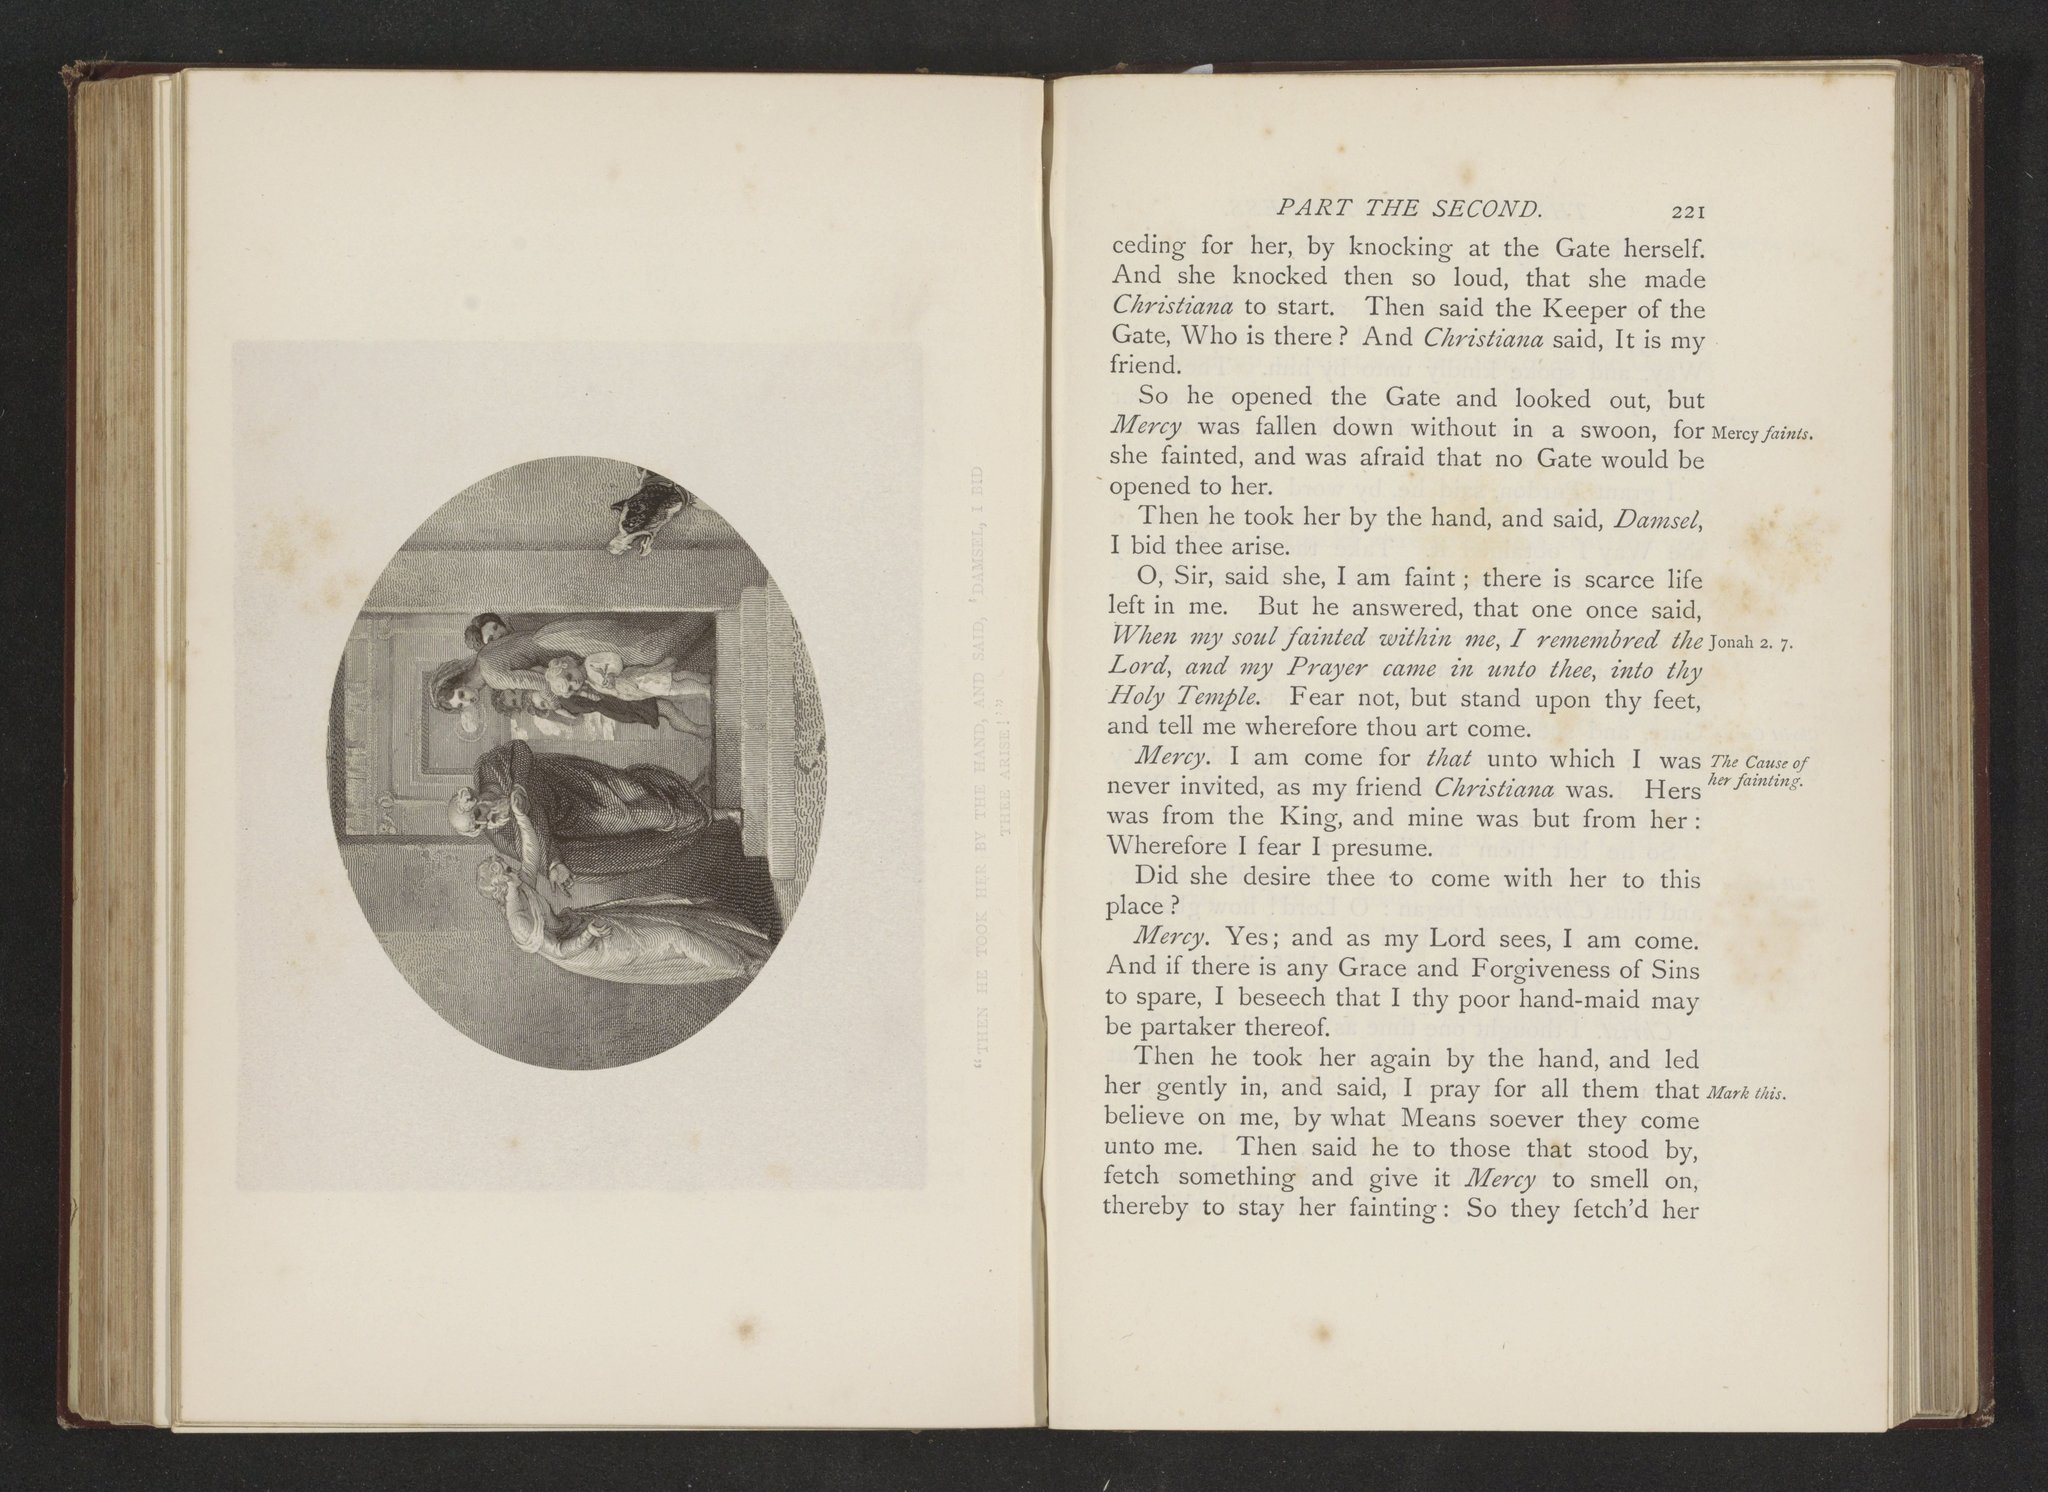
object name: reproduction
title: Fotoreproductie van een illustratie door Thomas Stothard voor Eens Christens reize naar de Eeuwigheid door John Bunyan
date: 1871-1881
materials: paper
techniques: woodburytype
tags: print, e.g.: engraving, etching, lithograph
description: Illustratie betreft Genade die bij een trap wordt geholpen door een man.